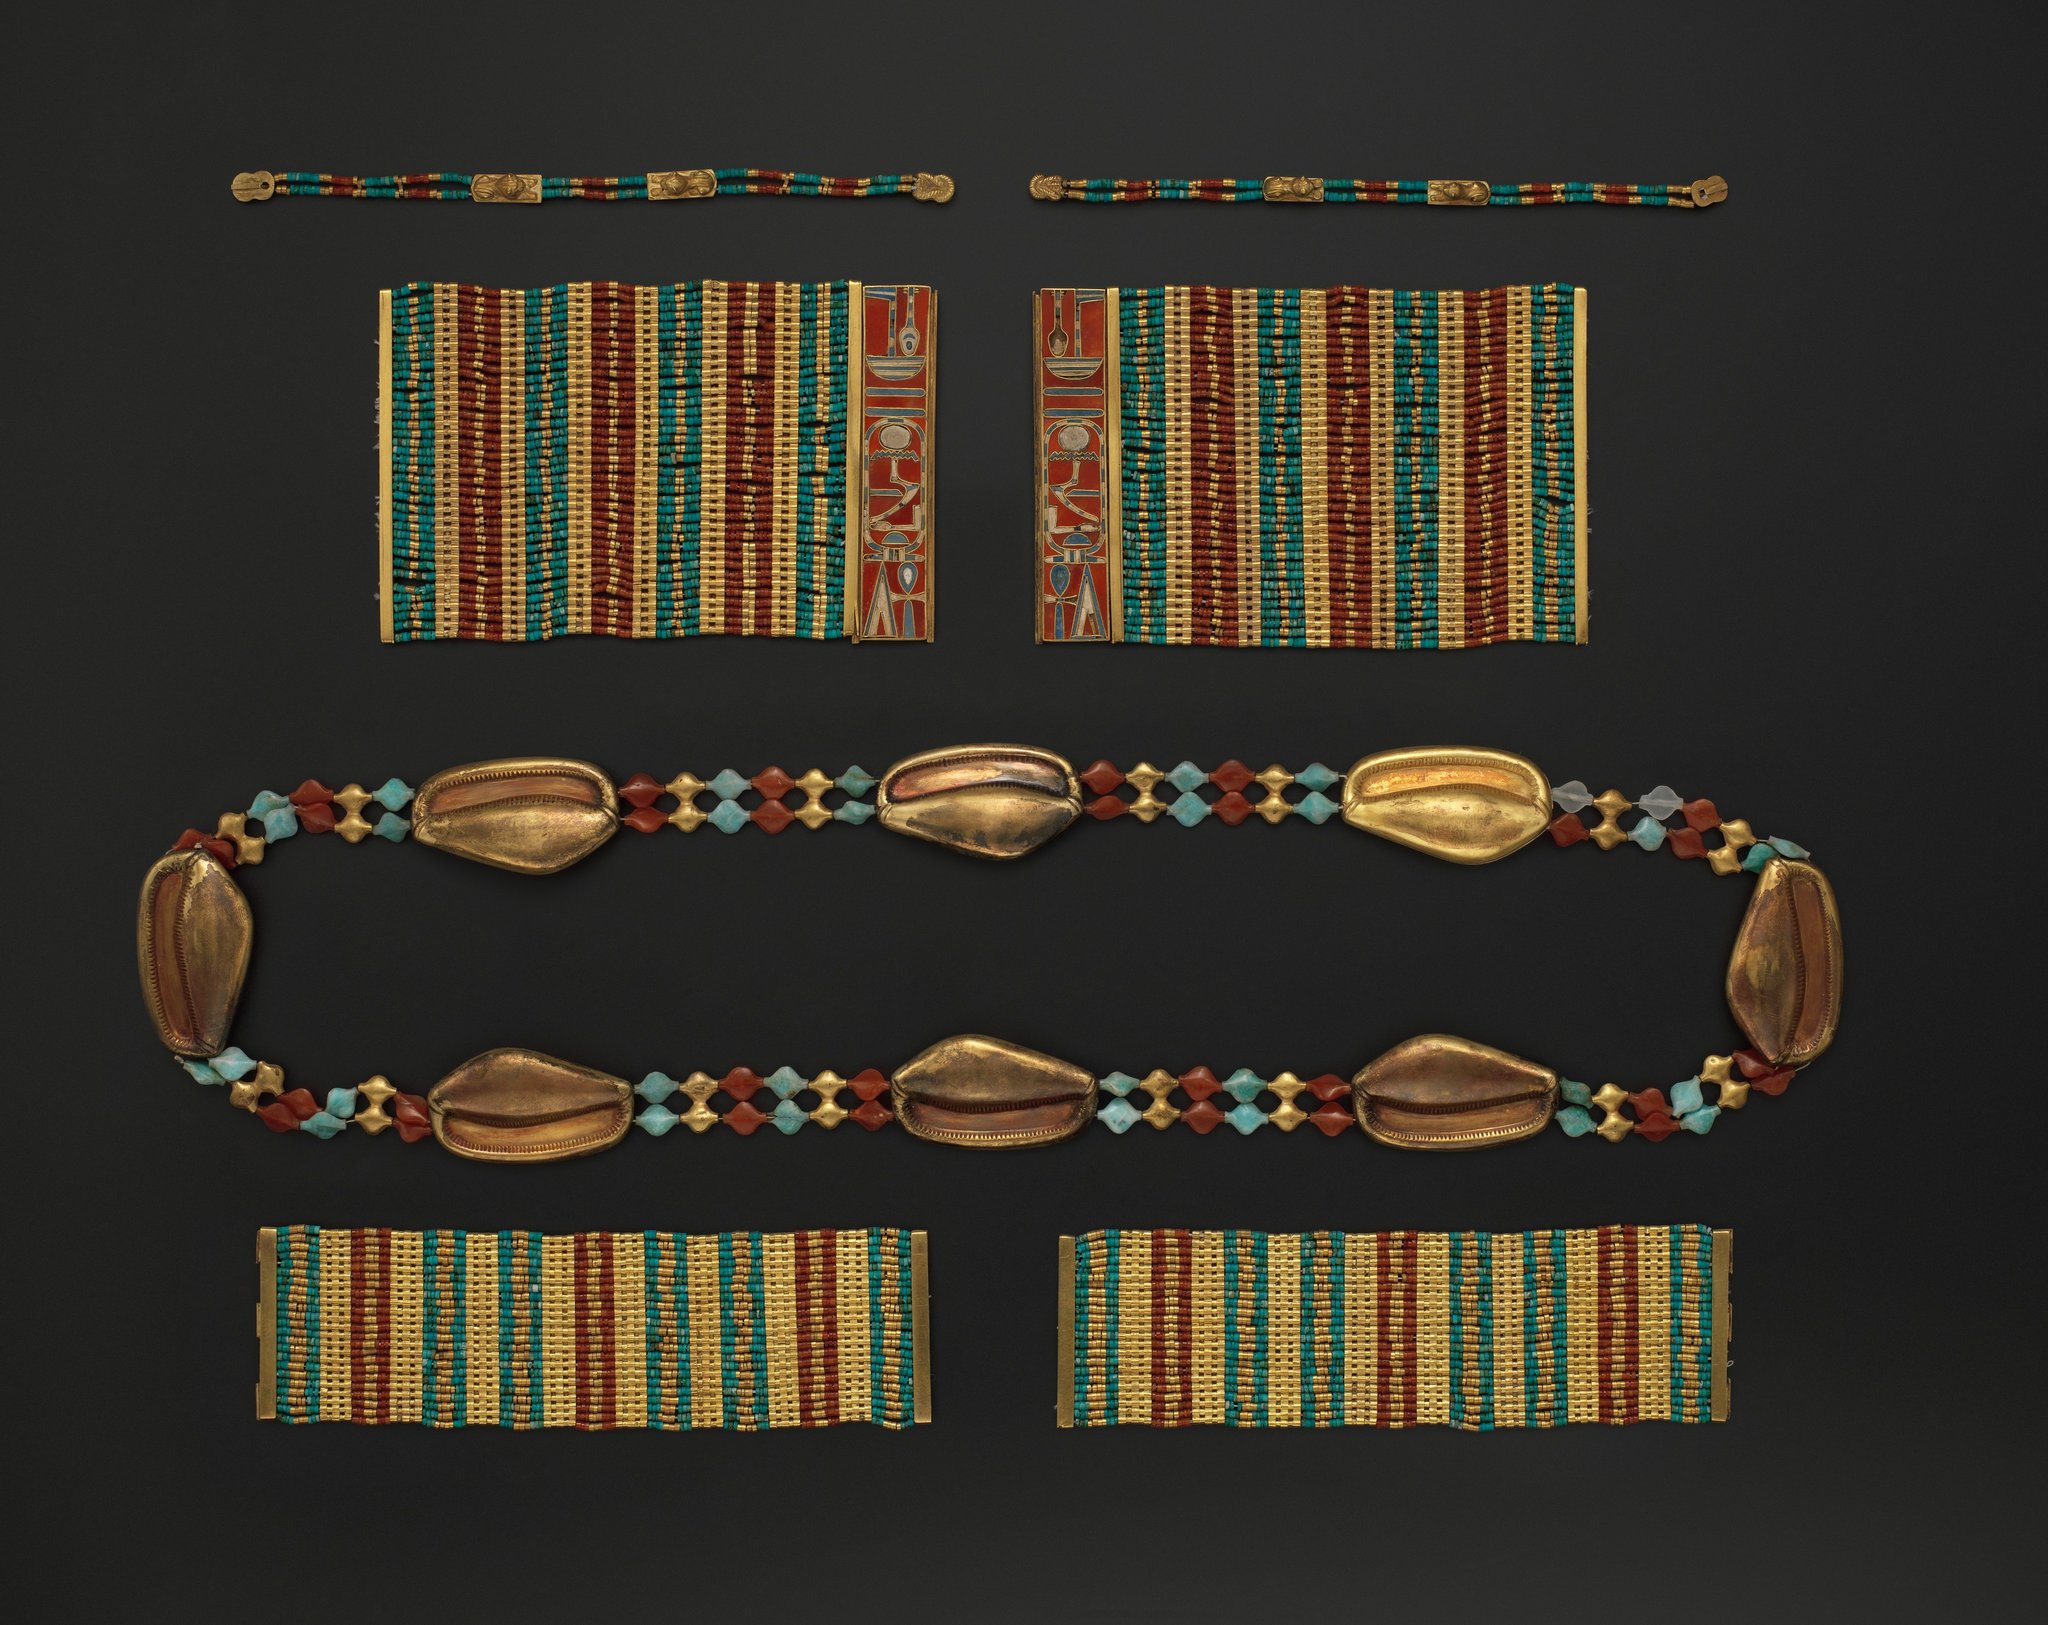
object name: bracelet, sithathoryunet, lion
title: Lion Bracelet of Sithathoryunet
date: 1887-1813 BCE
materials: gemstone, gold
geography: egypt